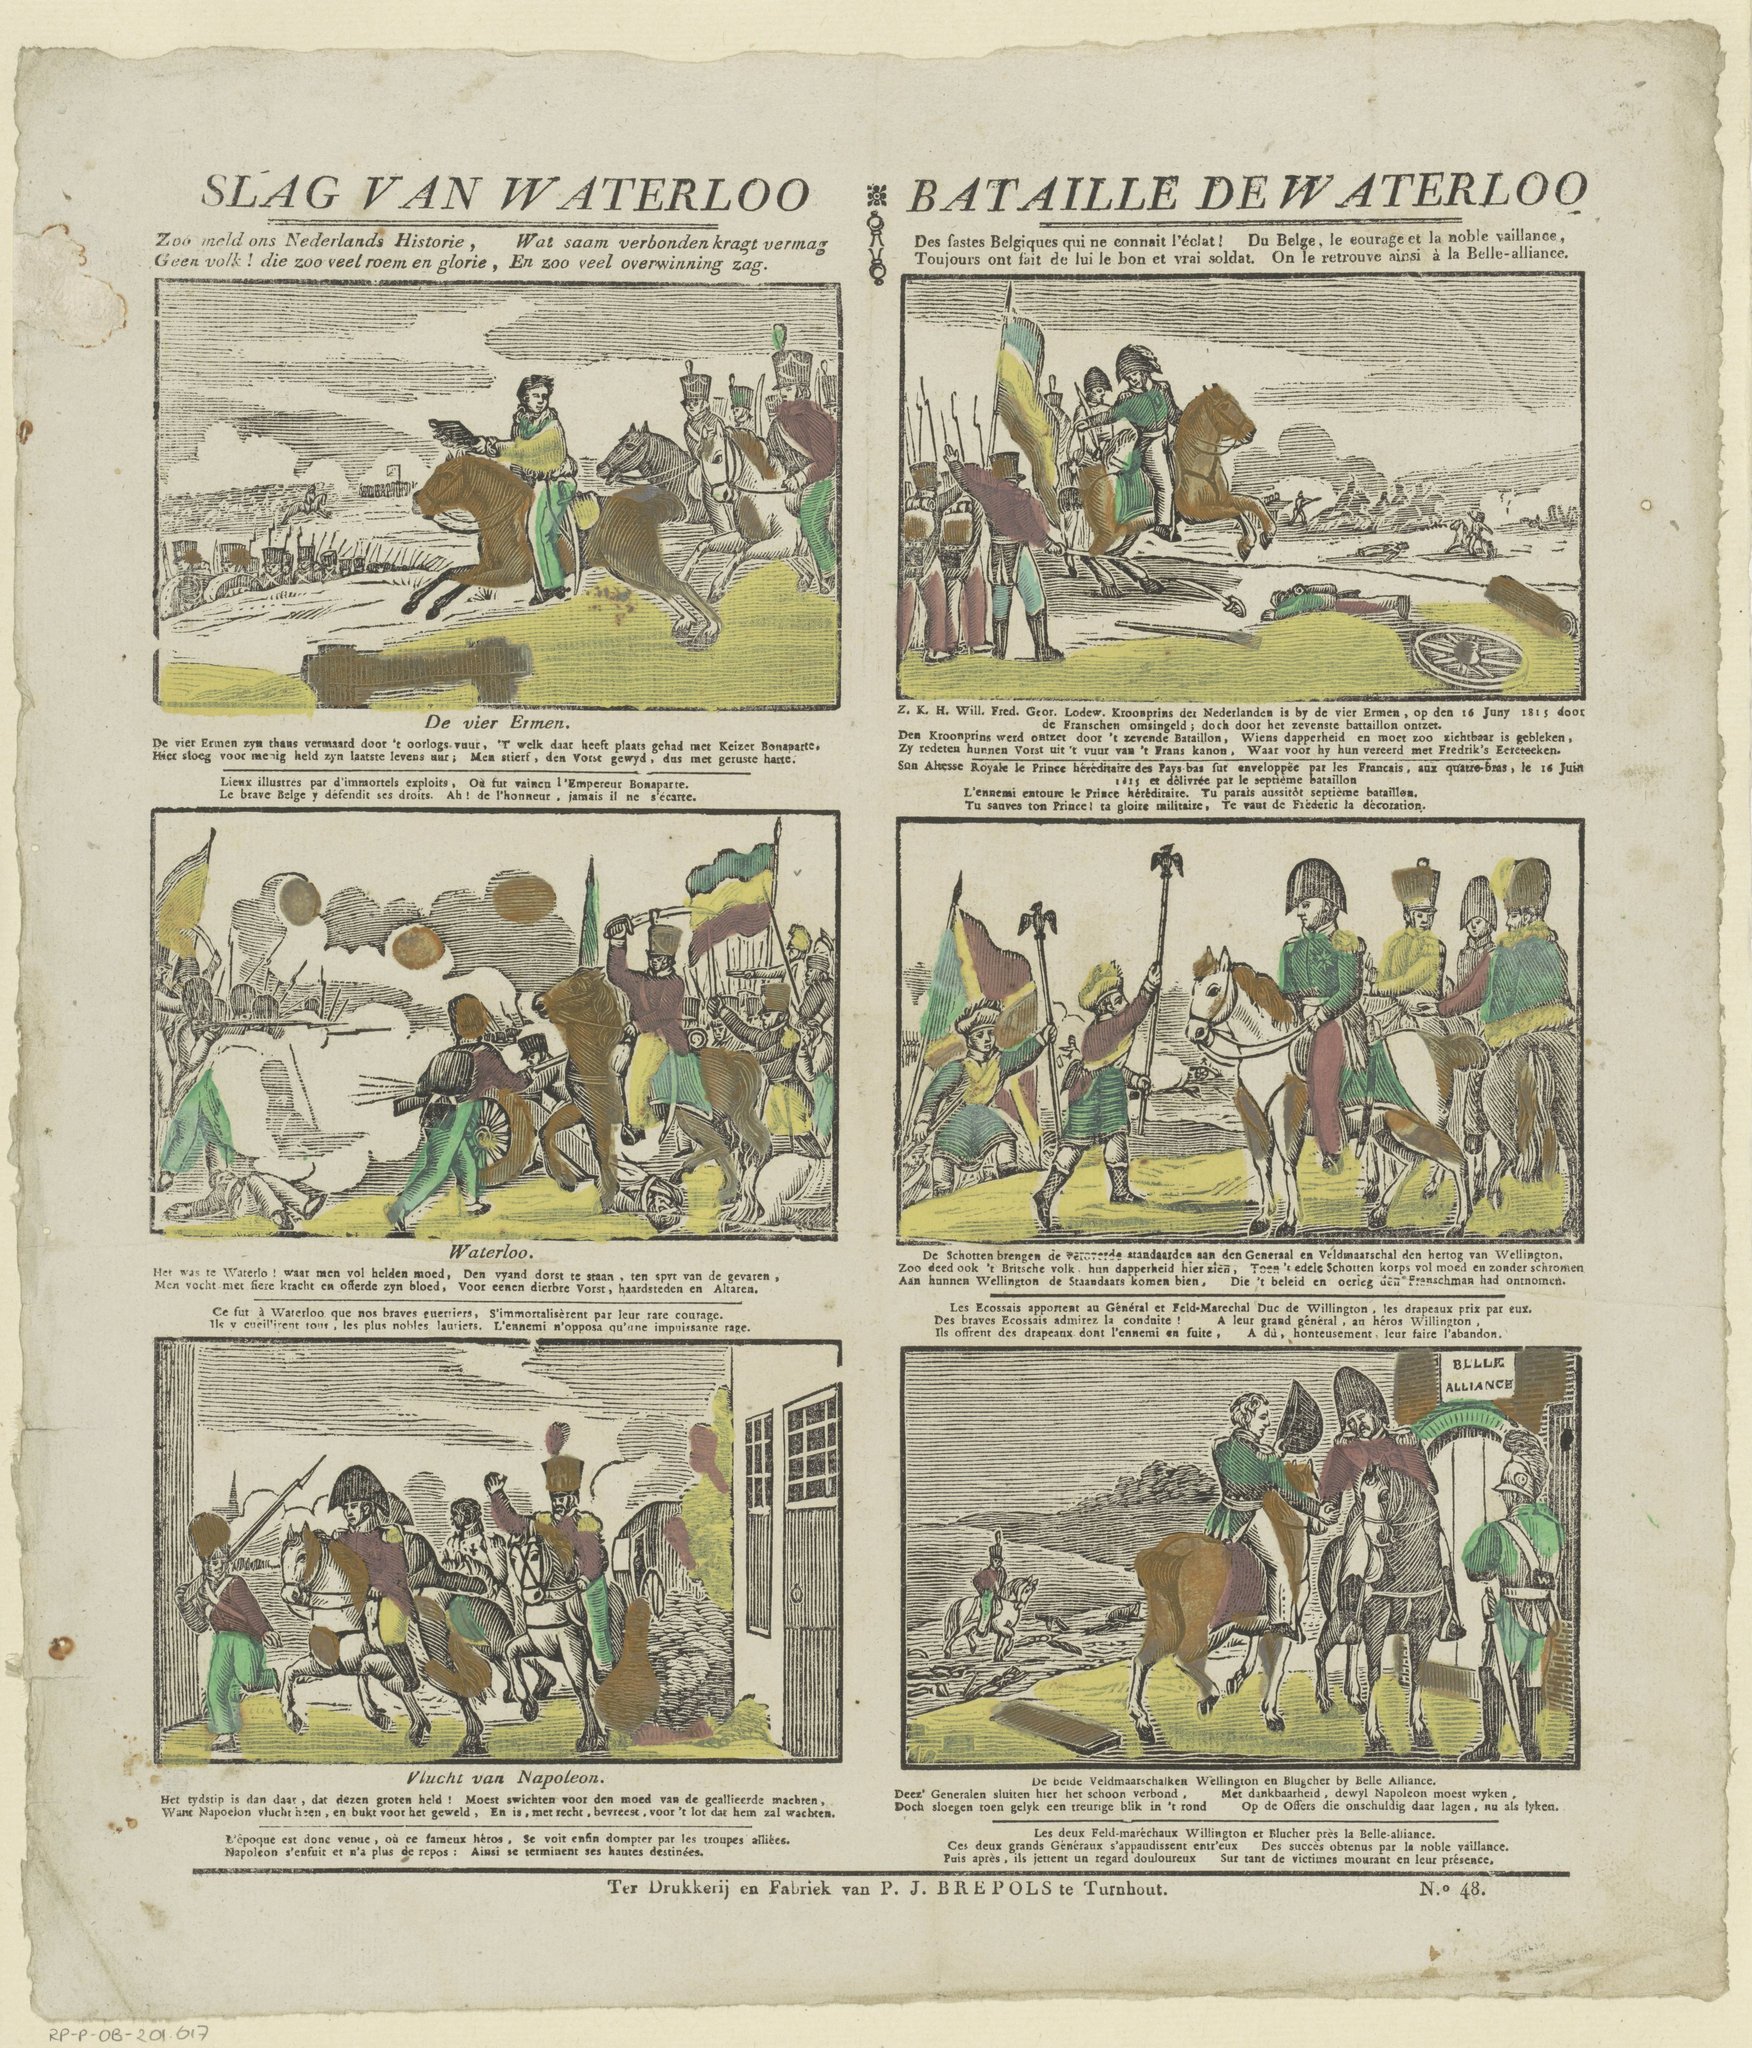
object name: popular print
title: Slag van Waterloo / Bataille de Waterloo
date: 1800-1833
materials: paper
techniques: colour, letterpress printing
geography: turnhout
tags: battle, the soldier; the soldier's life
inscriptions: collector's mark: Lugt 2760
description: Blad met 6 voorstellingen over de Slag bij Waterloo. Onder elke voorstelling een vierregelig vers in het Nederlands en in het Frans. Genummerd rechtsonder: No. 48.